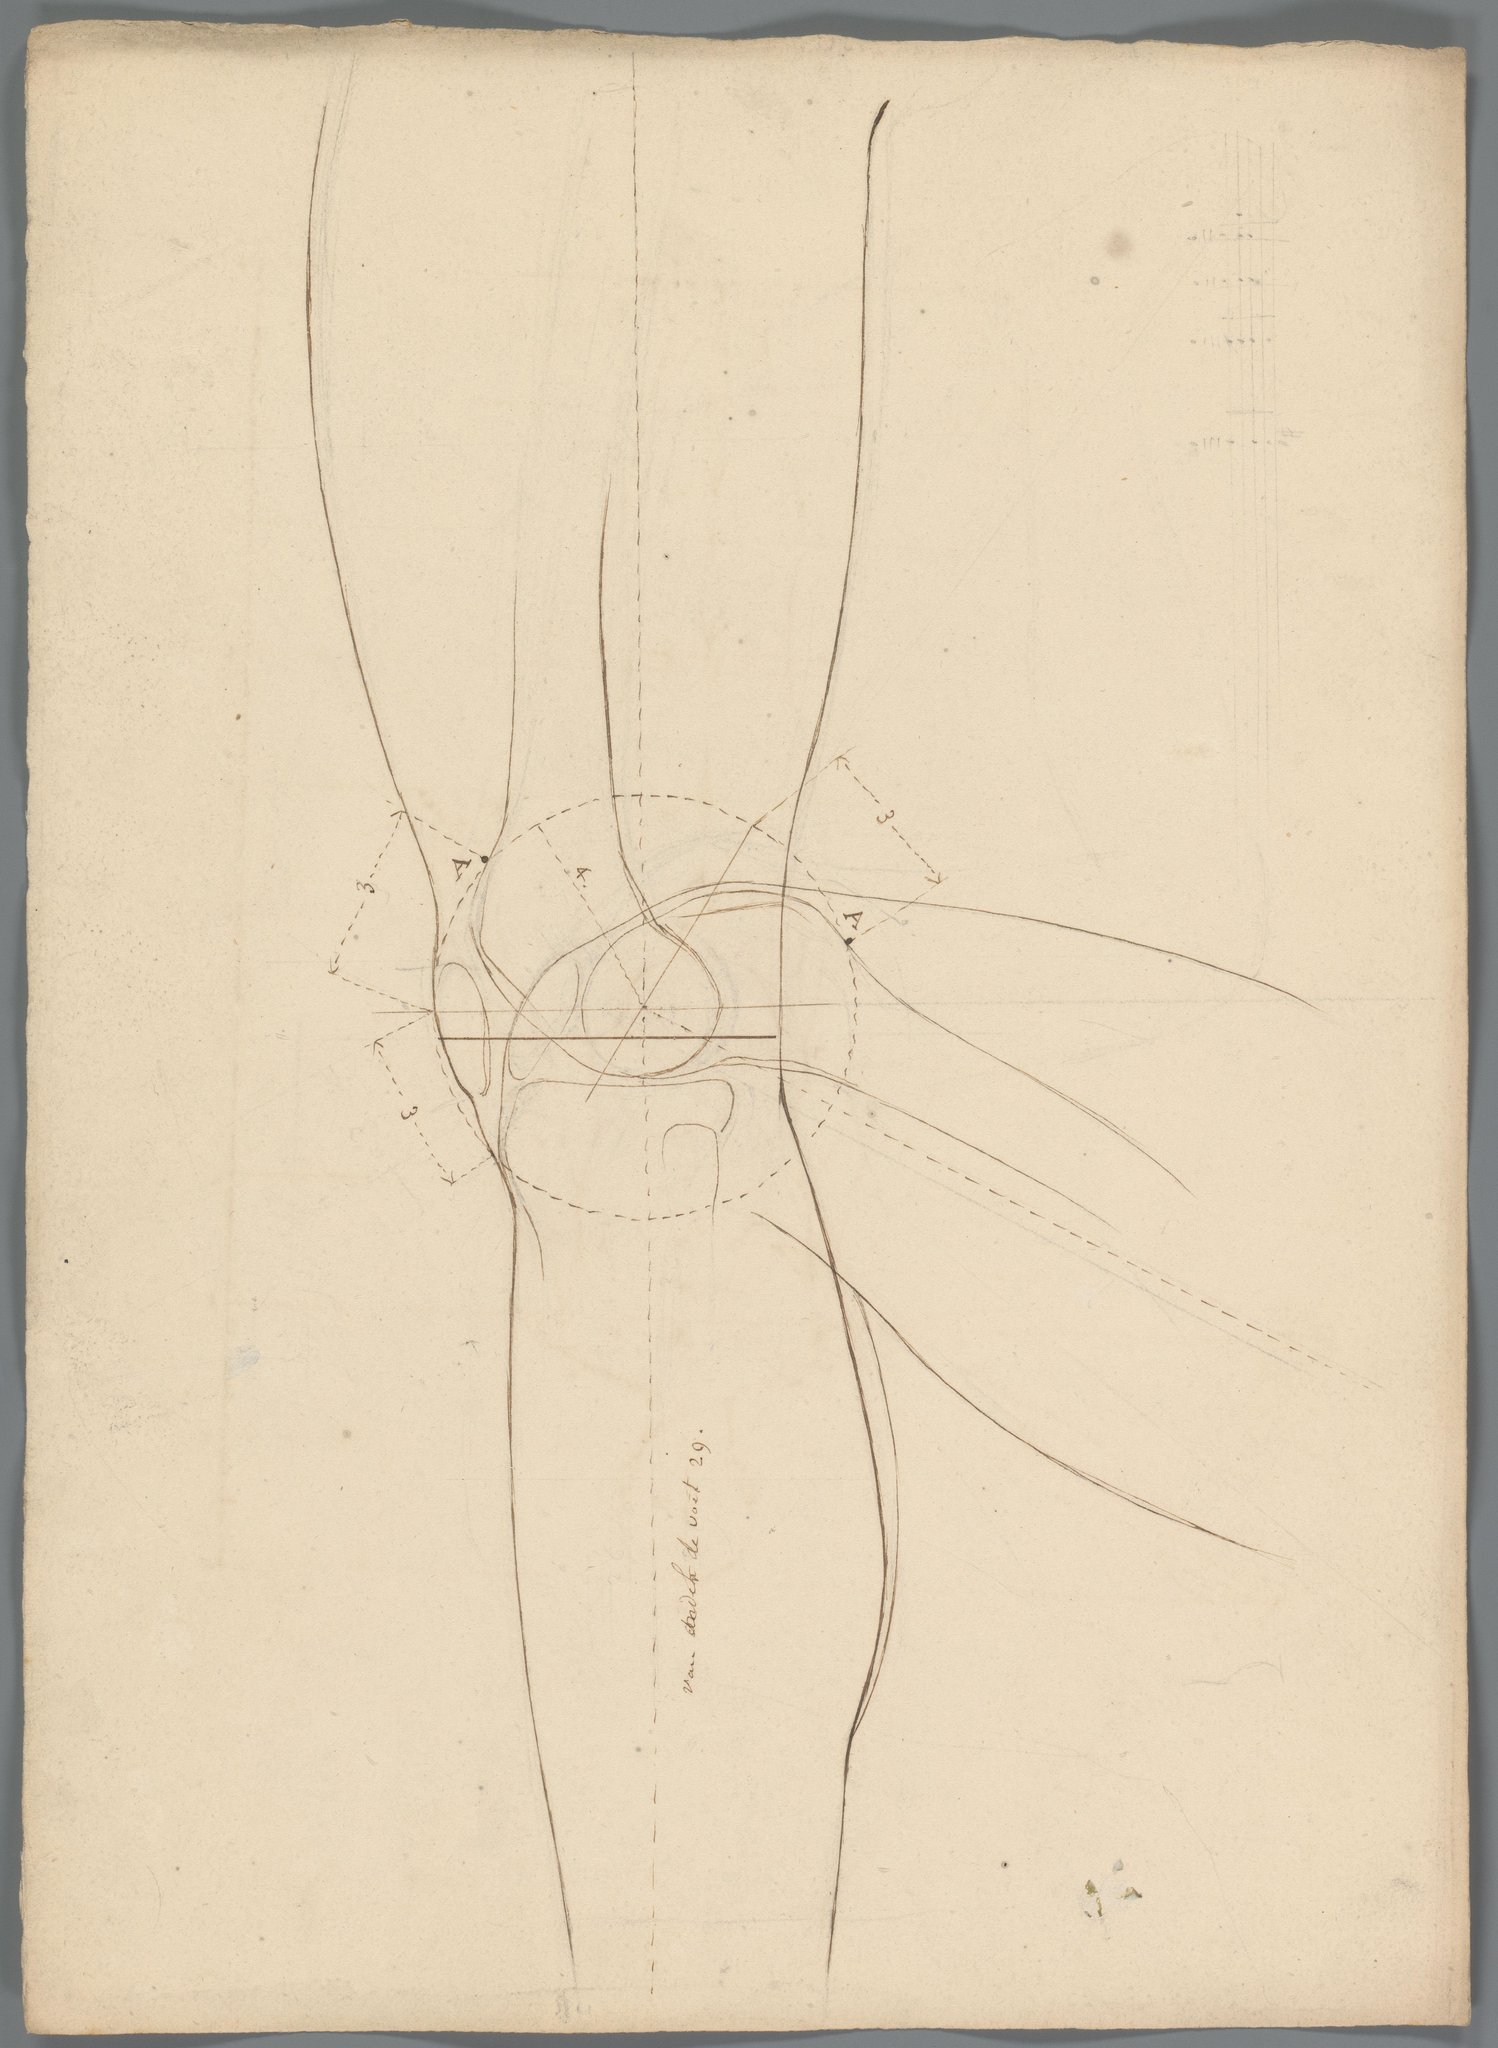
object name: drawing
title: Studie van het kniegewricht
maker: jacobus everhardus josephus van den berg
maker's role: draughtsman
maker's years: 1802-1861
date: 1812-1861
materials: ink, paper, pencil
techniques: pen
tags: knee, bones of the legs